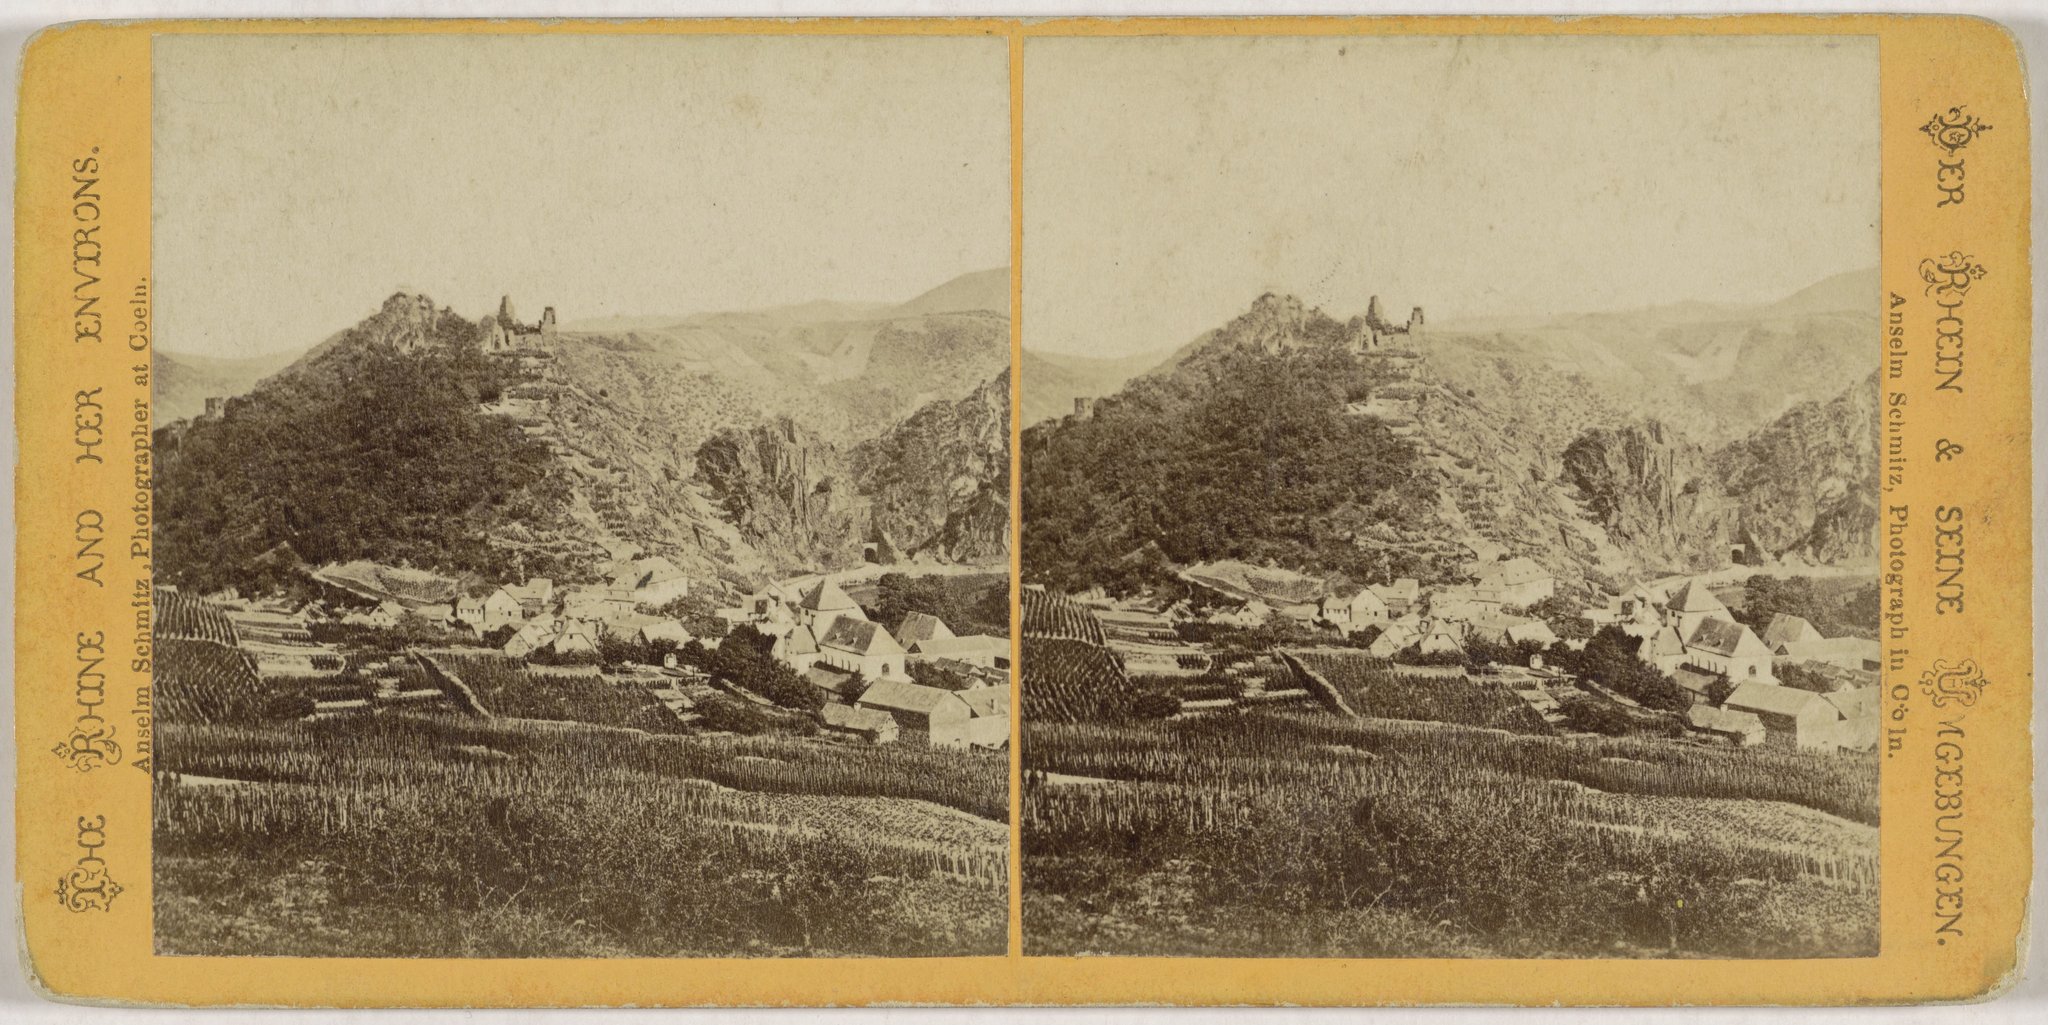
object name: stereograph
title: Gezicht op Altenahr en Burg Are in het Ahrdal, Duitsland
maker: anselm schmitz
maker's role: publisher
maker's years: 1831-1903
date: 1880-1890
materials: cardboard, paper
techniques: albumen print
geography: altenahr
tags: dale, valley, village, landscape with ruins